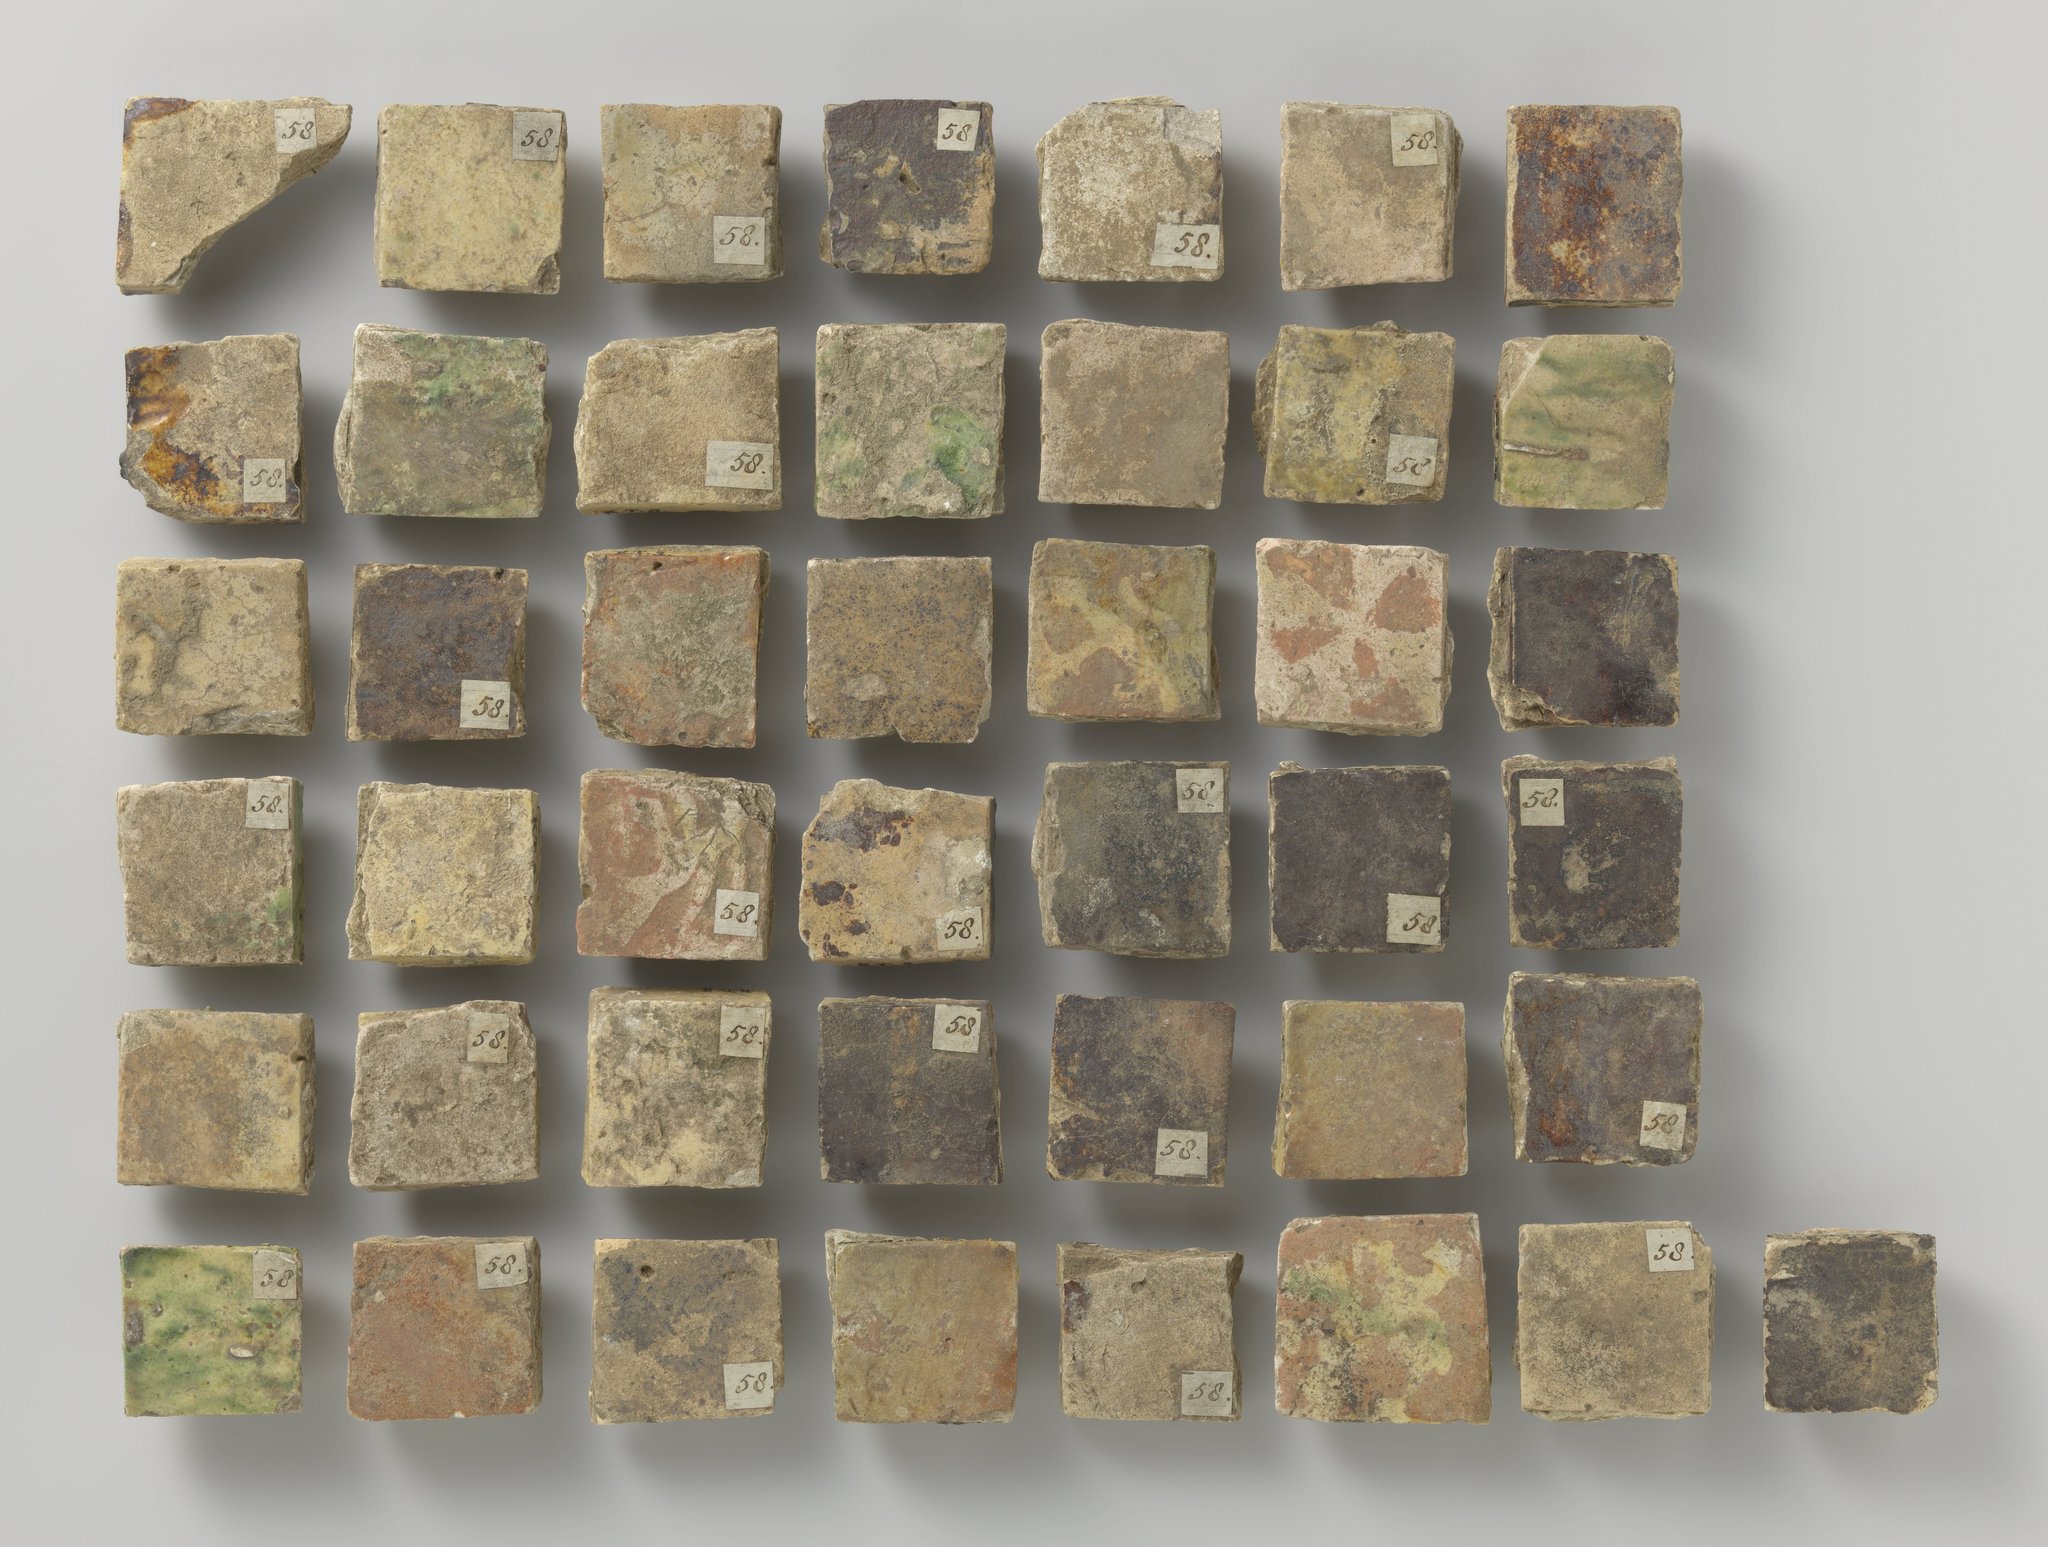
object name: architectural element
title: Drieënveertig vloertegels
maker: Anonymous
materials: earthenware, glaze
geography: netherlands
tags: kessel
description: Drieënveertig groen en rood geglazuurde vierkante tegels, vermoedelijk vloertegels.